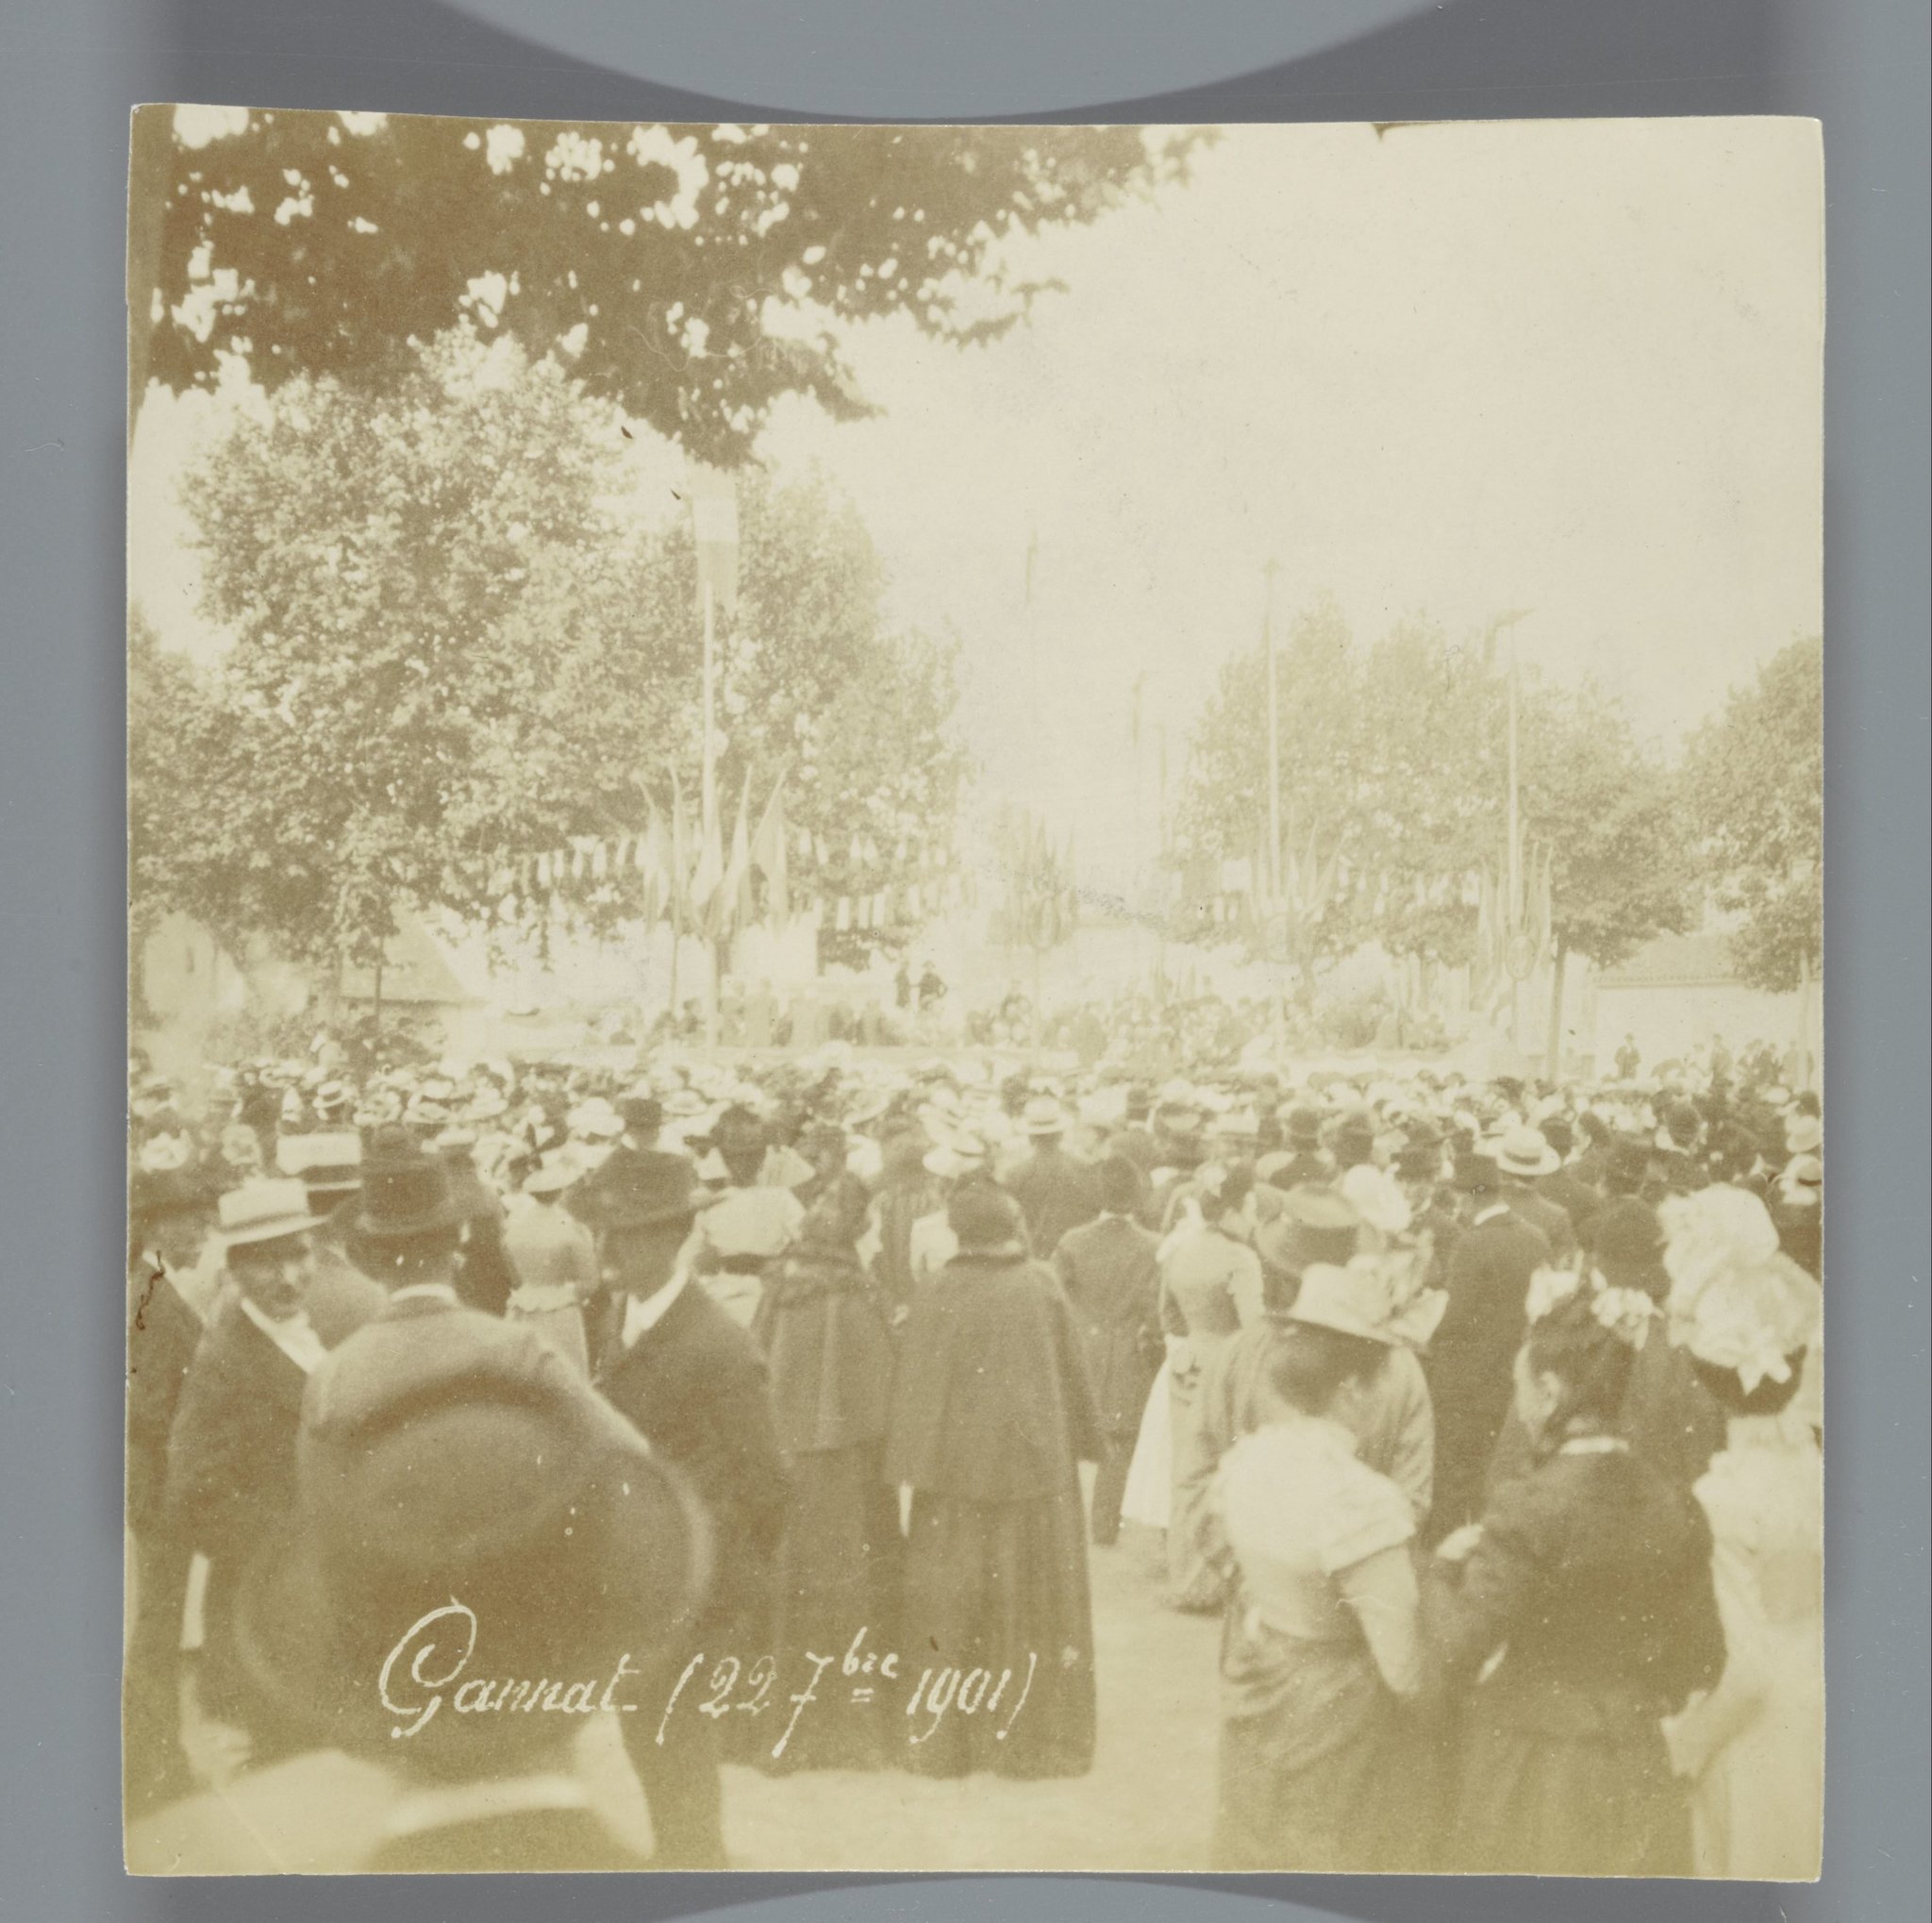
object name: photograph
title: Menigte in Gannat (Allier), Frankrijk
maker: Anonymous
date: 1901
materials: paper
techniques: gelatin silver print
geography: france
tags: village square, place (+ city(-scape) with figures, staffage), france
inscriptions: annotation: ‘Gannat (22 7bre 1901)’